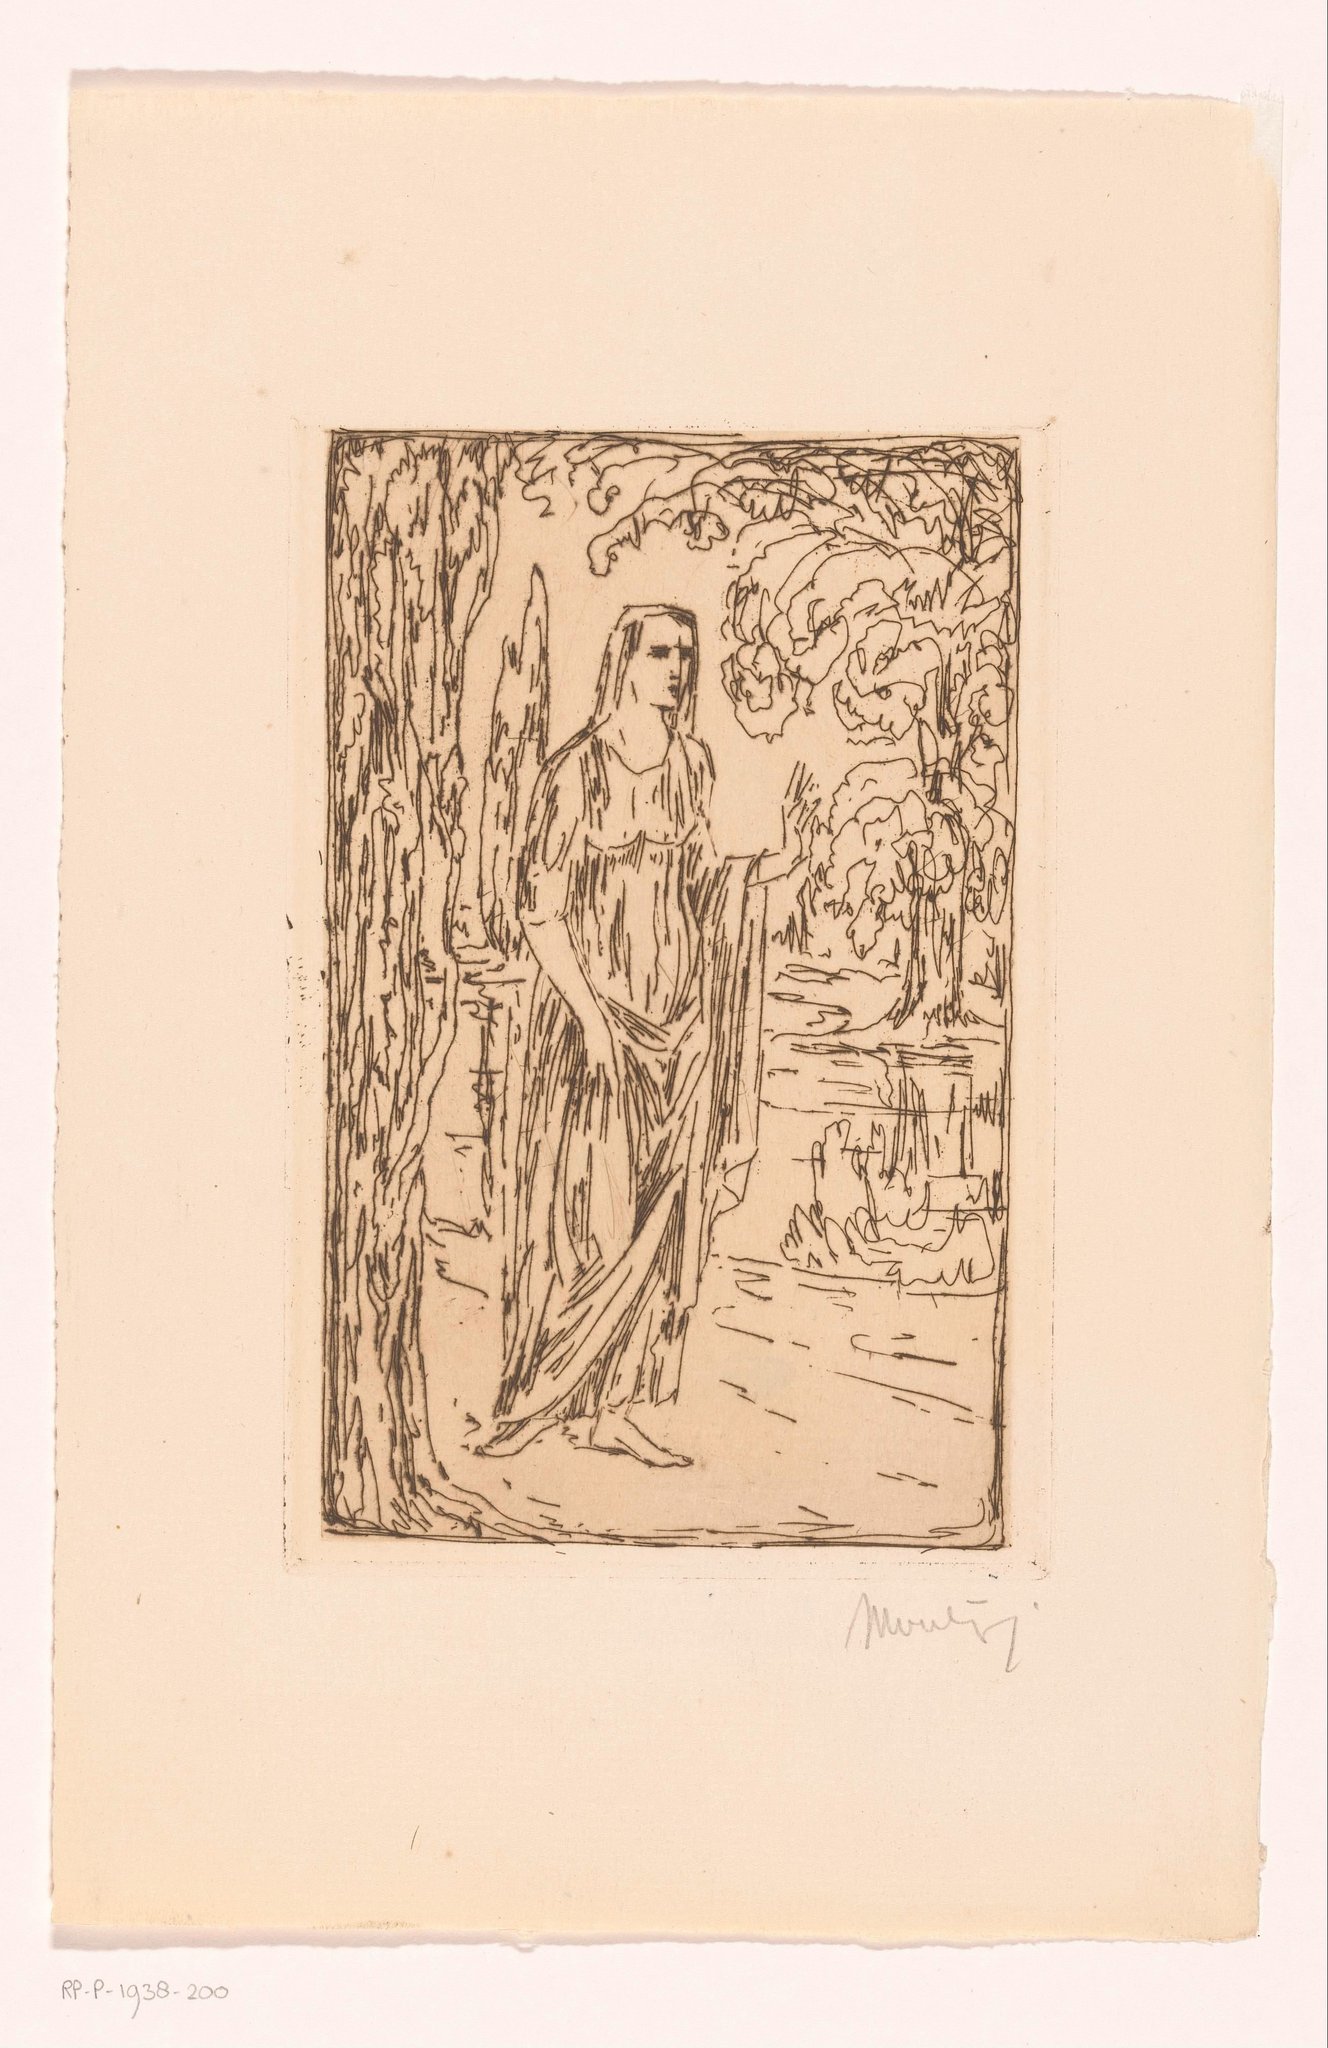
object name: print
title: Vrouwenfiguur in landschap met cipressen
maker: simon moulijn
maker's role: draughtsman, print maker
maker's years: 1866-1948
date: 1908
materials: paper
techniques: etching, intaglio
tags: trees: cypress, standing figure - aa - female human figure, dress, gown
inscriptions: collector's mark: Lugt 2228, collector's mark: Lugt 2760